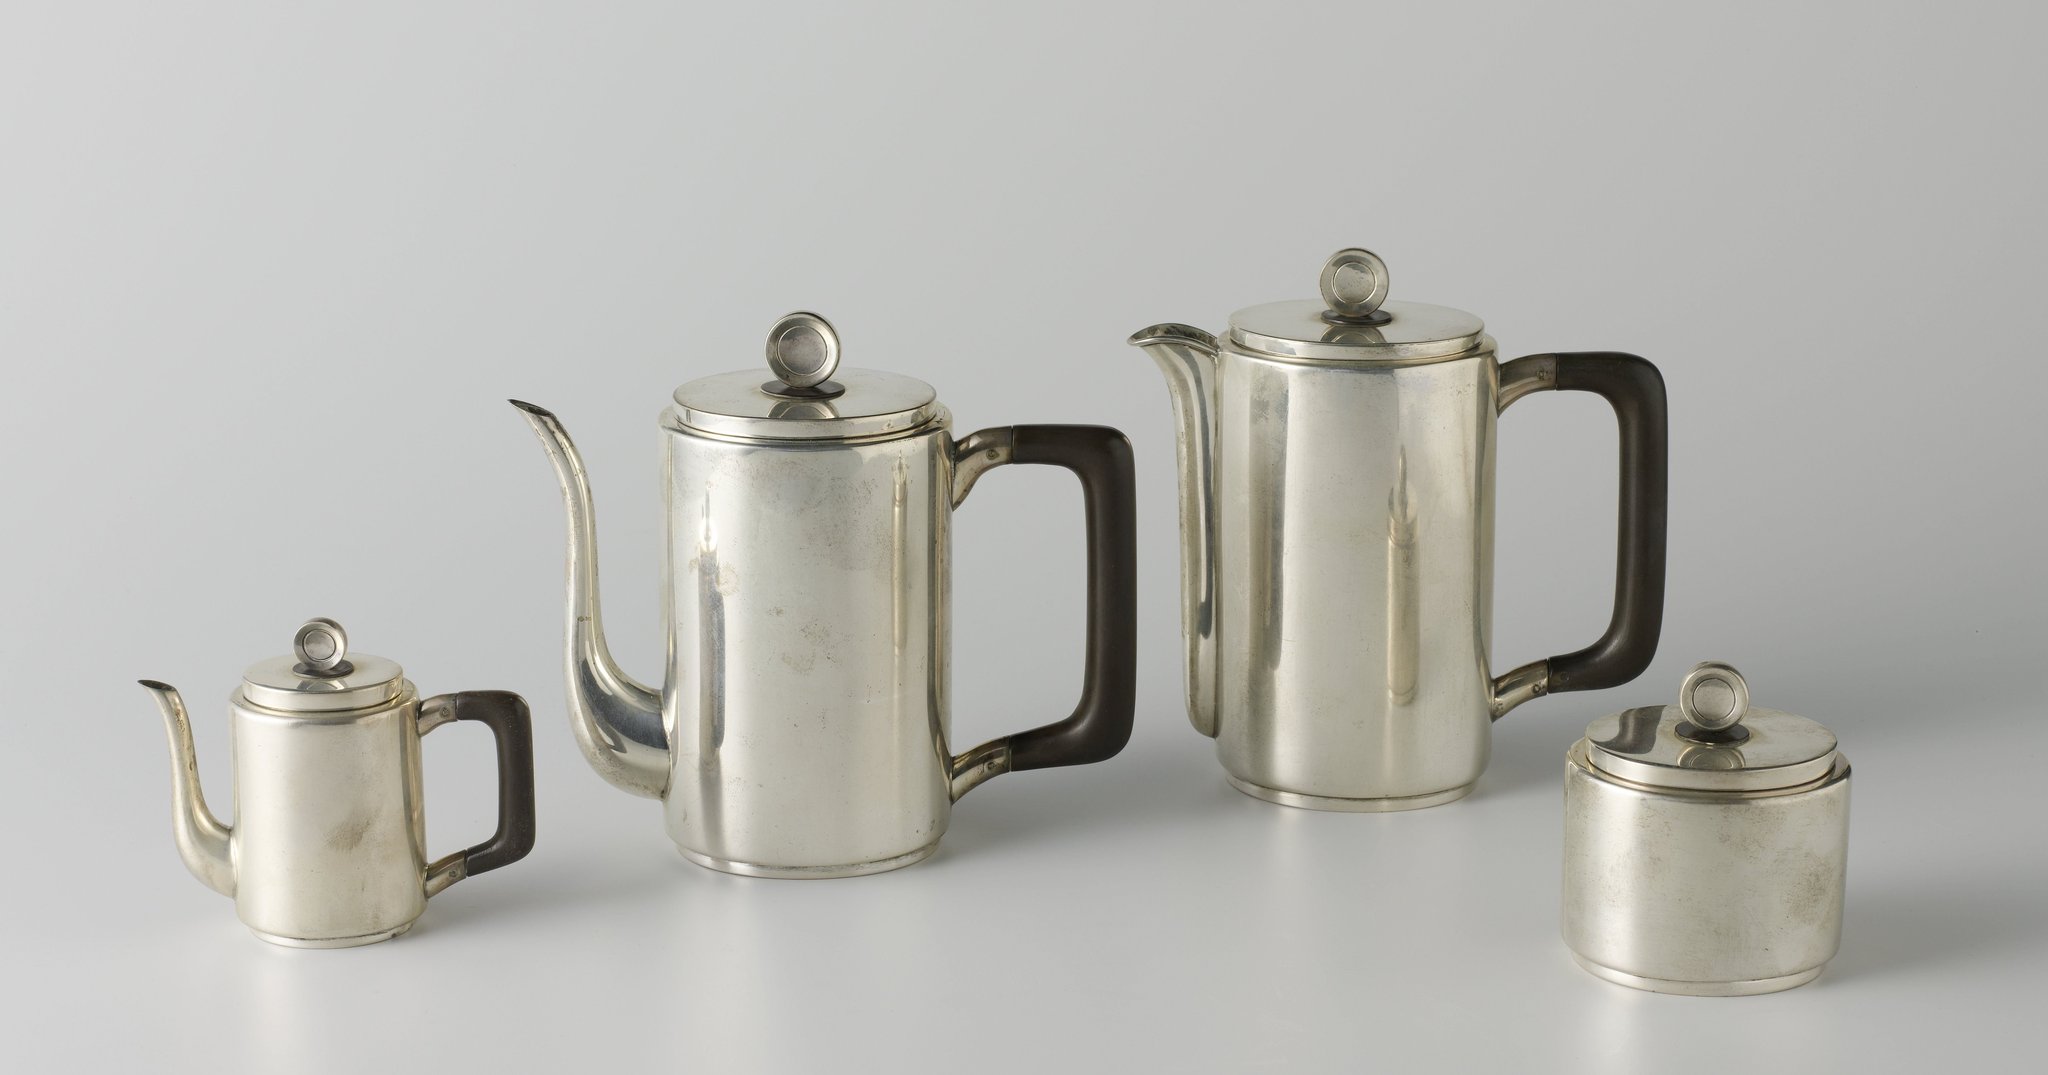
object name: coffee pot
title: Koffiekan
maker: johannes steltman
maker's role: silversmith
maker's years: 1891-1961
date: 1940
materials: silver, wood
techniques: casting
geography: the hague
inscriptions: date letter: ‘F (=1940)’, retailer's mark: ‘J. Steltman, C2 in rechthoek’, hallmark: ‘Minervakop met C (=keurkamer Den Haag)’, maker's mark, hallmark: ‘leeuw 2’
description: Rechtwandige koffiekan, ovaal in doorsnede met een C-vormig gebogen zwart houten oor met zilveren aanzetten, en een hoge S-vormig gebogen tuit. Gemerkt en gedateerd. Kan maakt deel uit van een koffieservies.